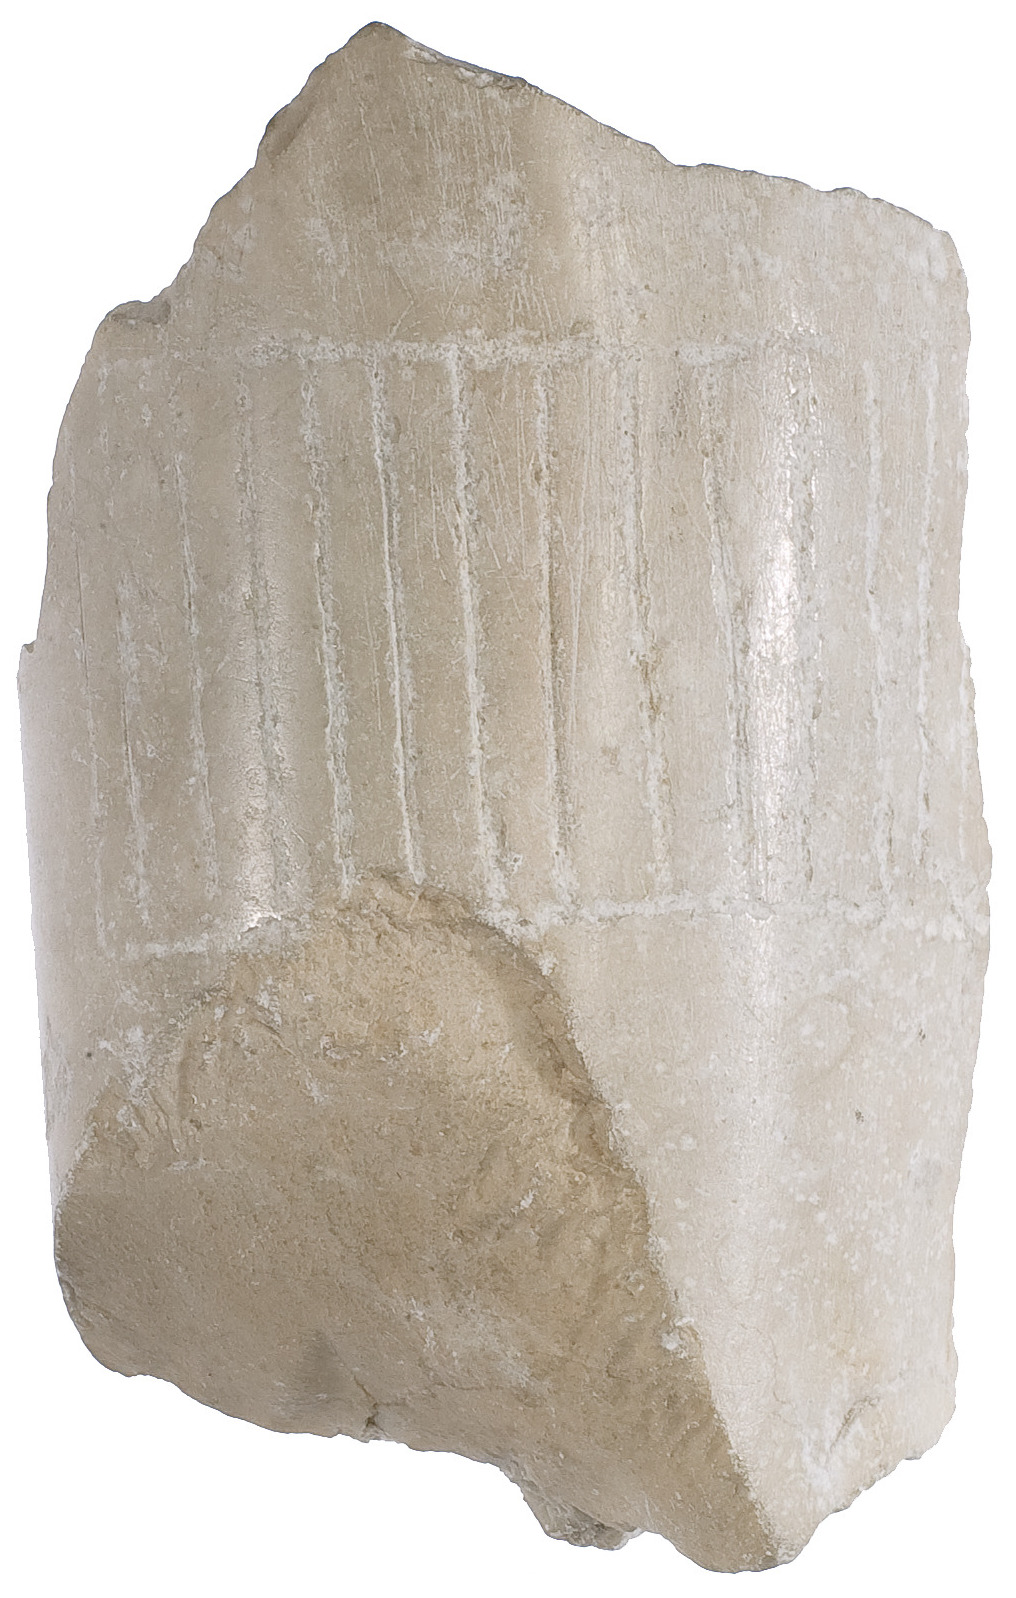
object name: limb with garment edge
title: Pleated garment with selvage at ankle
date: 1353-1336 BCE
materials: limestone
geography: egypt